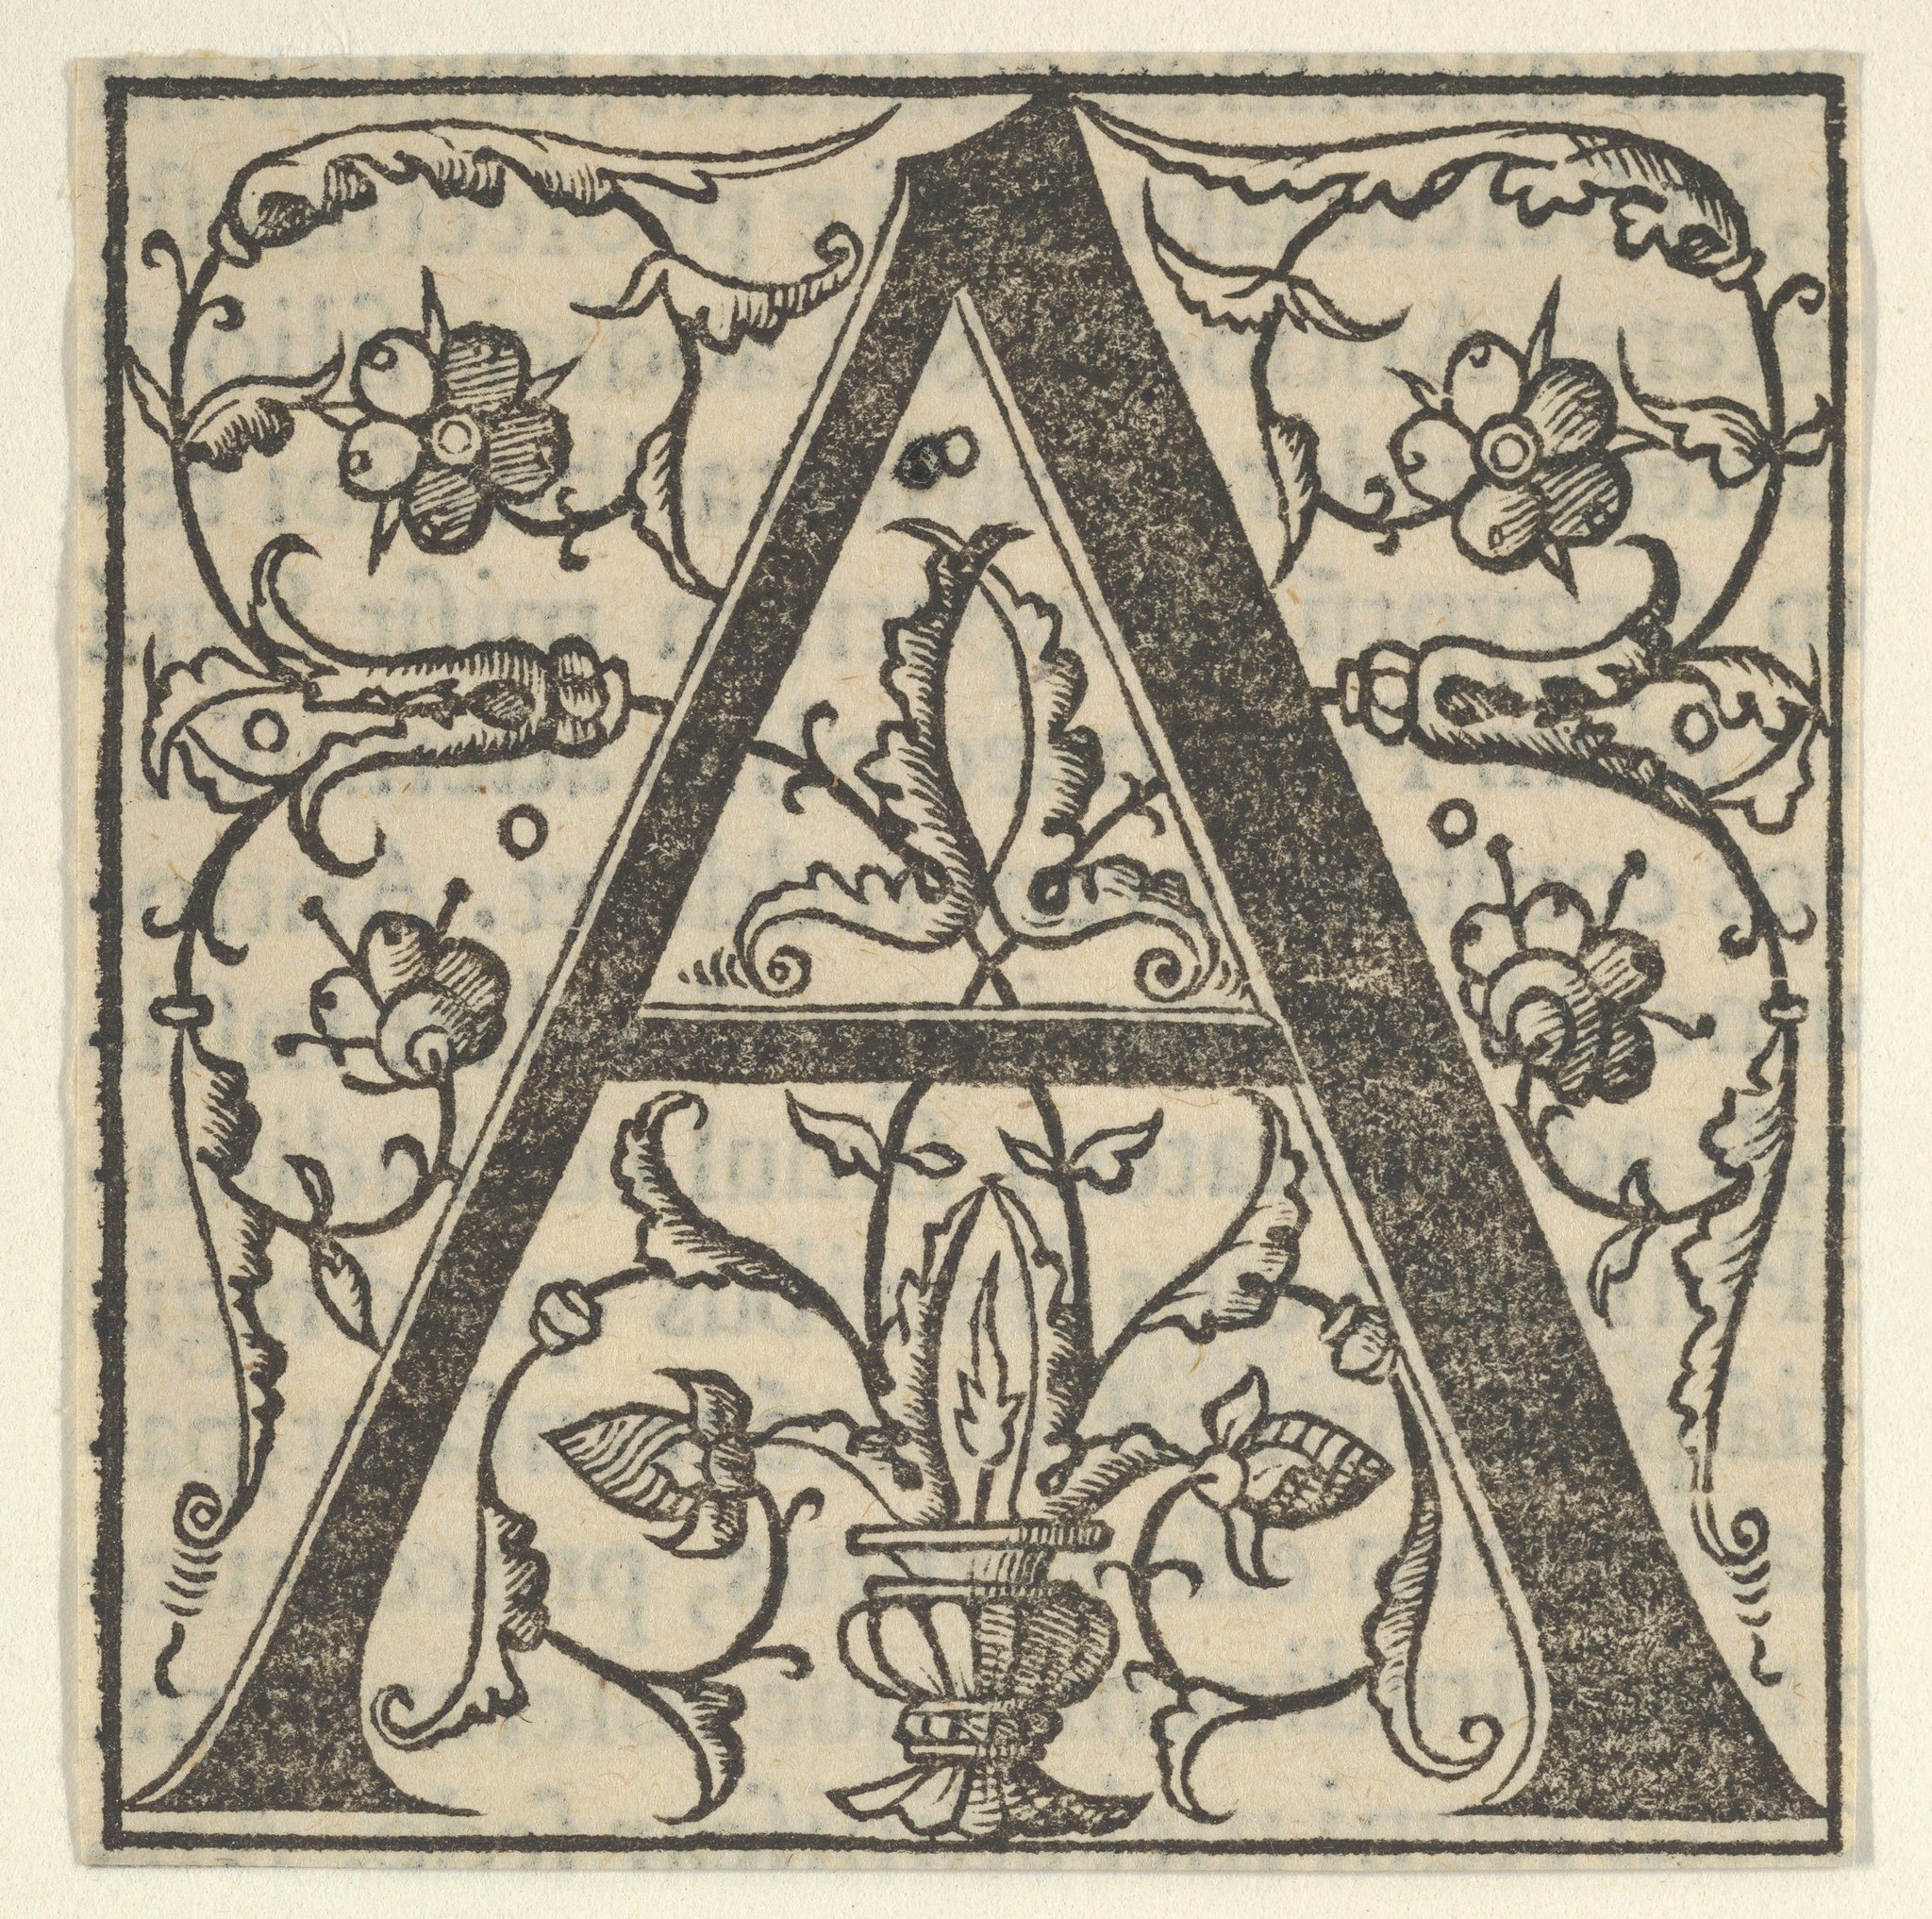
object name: print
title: Initial letter A with garlands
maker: oronce finé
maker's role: artist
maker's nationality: french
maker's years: 1494-1555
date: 1534-1566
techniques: woodcut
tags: flowers,leaves